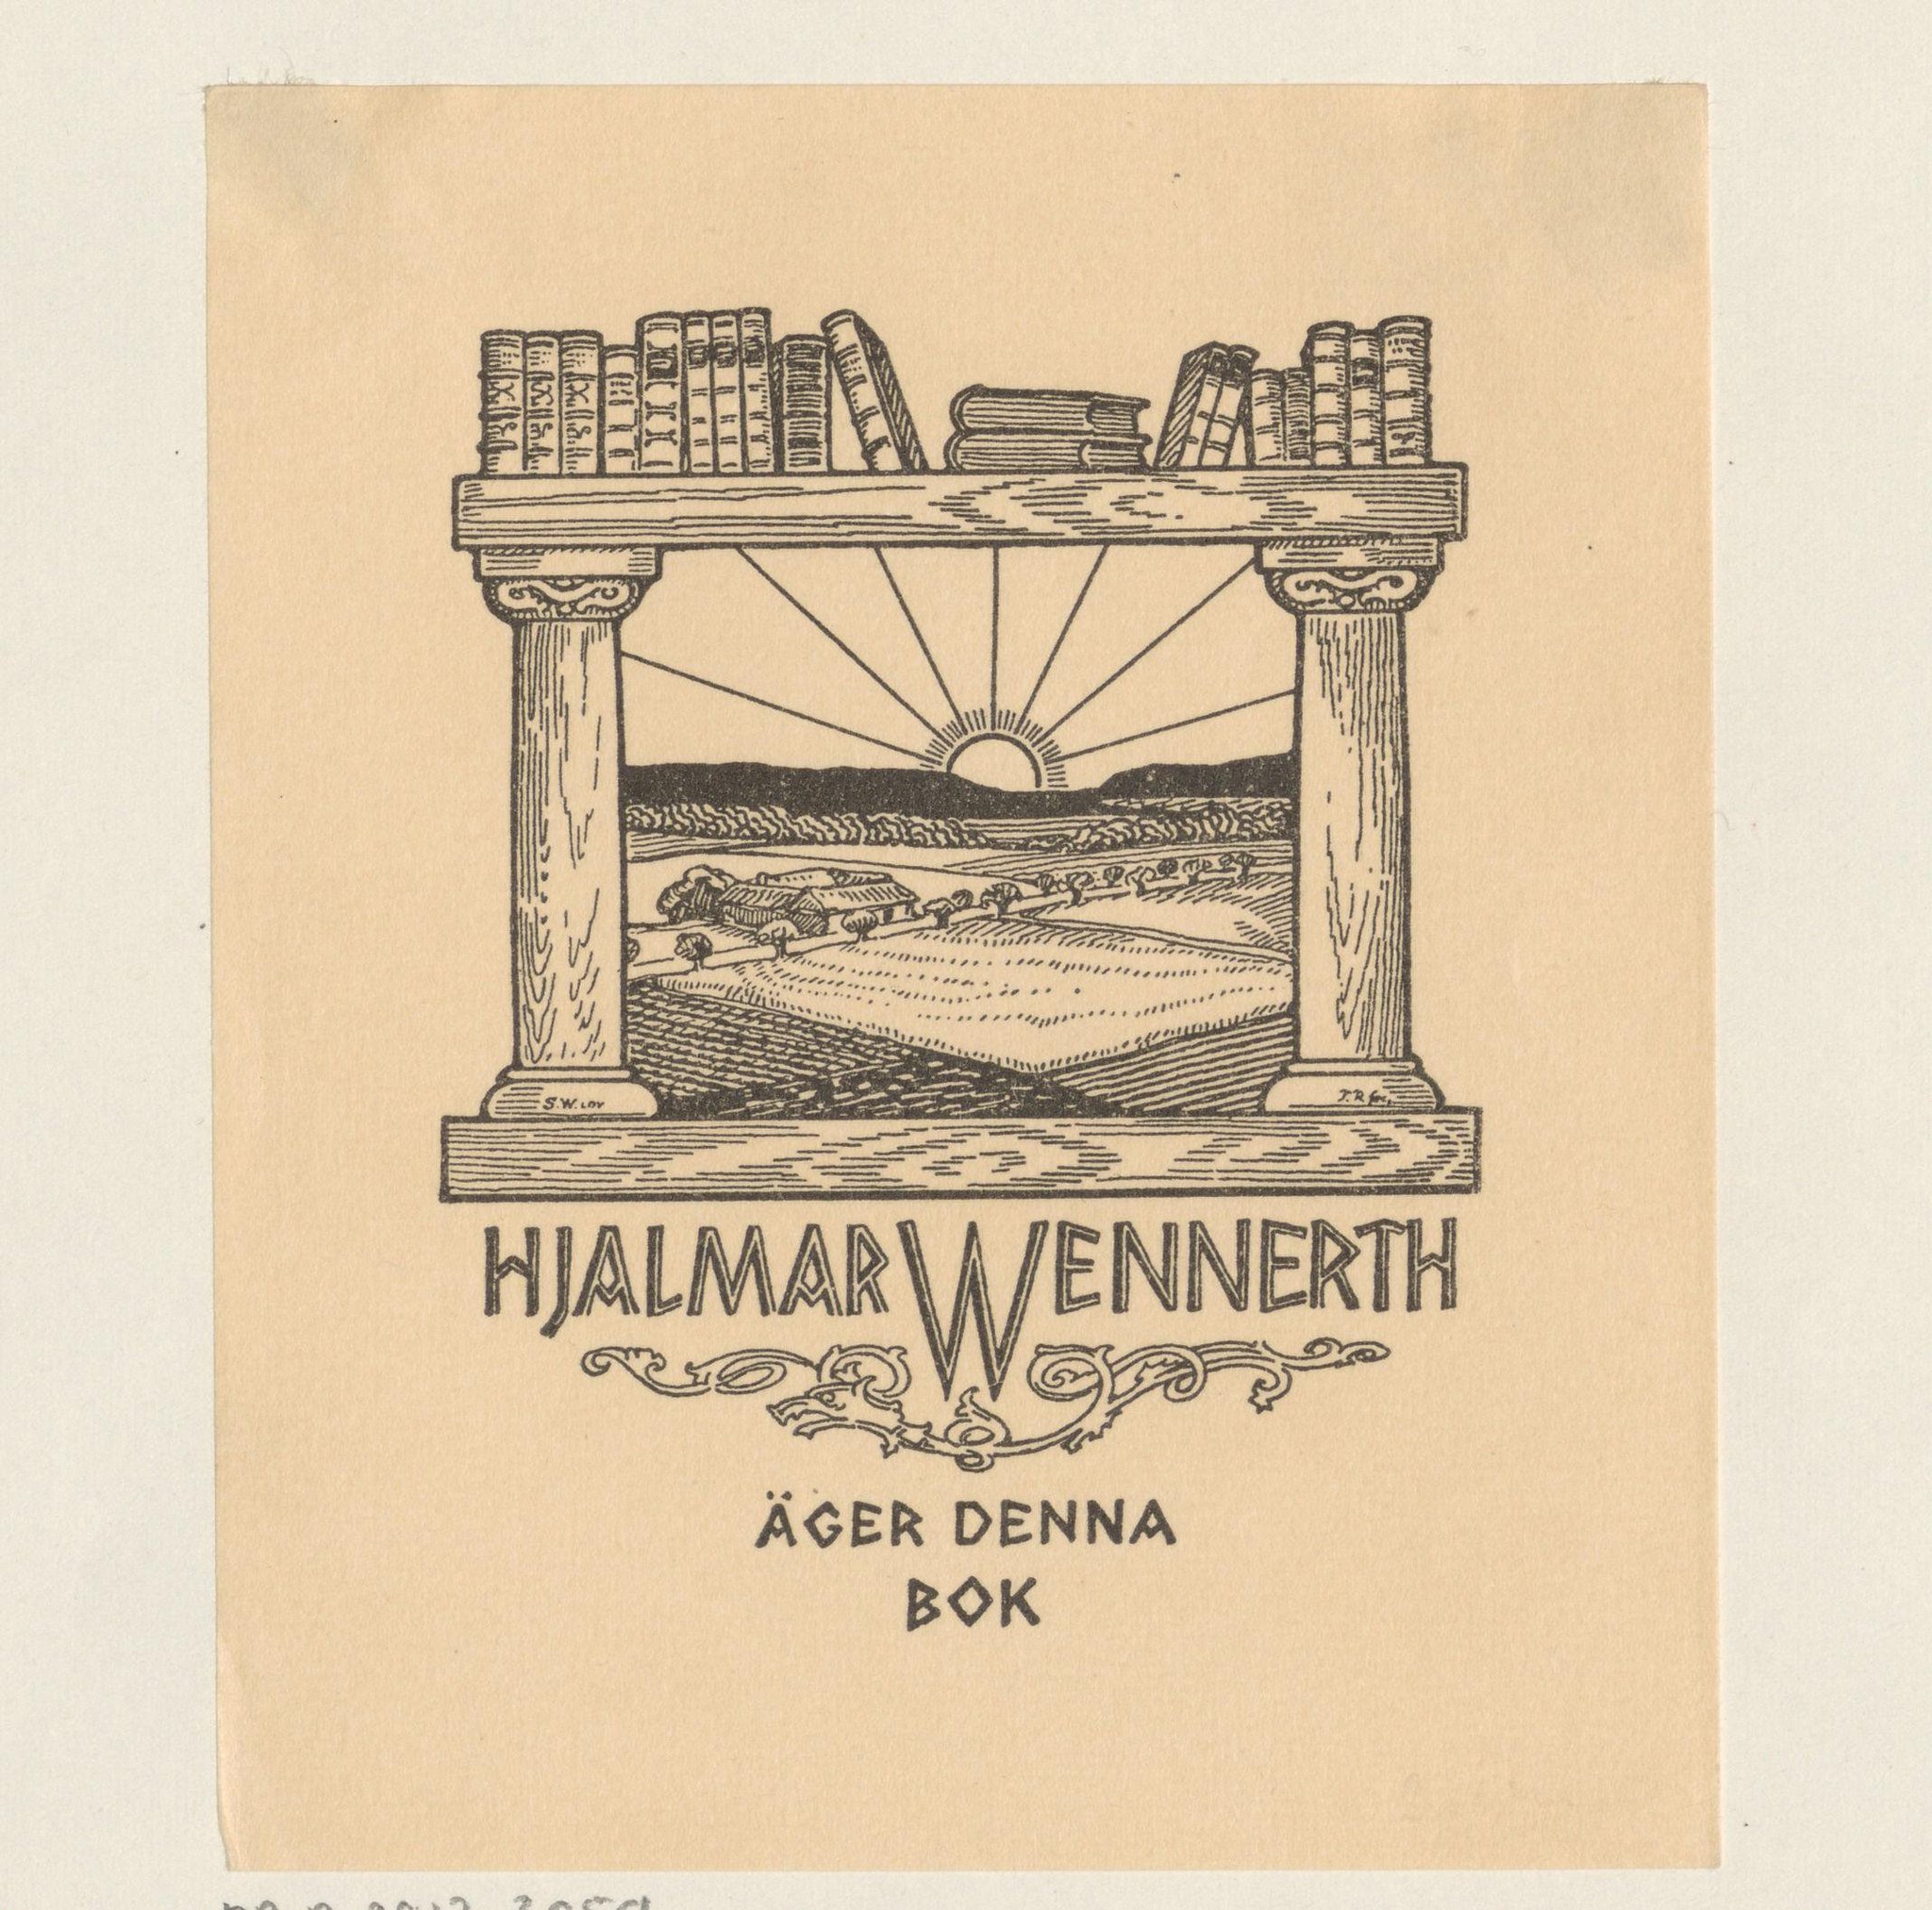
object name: bookplate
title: Ex libris van Hjalmar Wennerth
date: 1900-1999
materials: paper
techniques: printing block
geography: sweden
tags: bookshelves, column, pillar ~ architecture, meadow, pasture, book, sunset